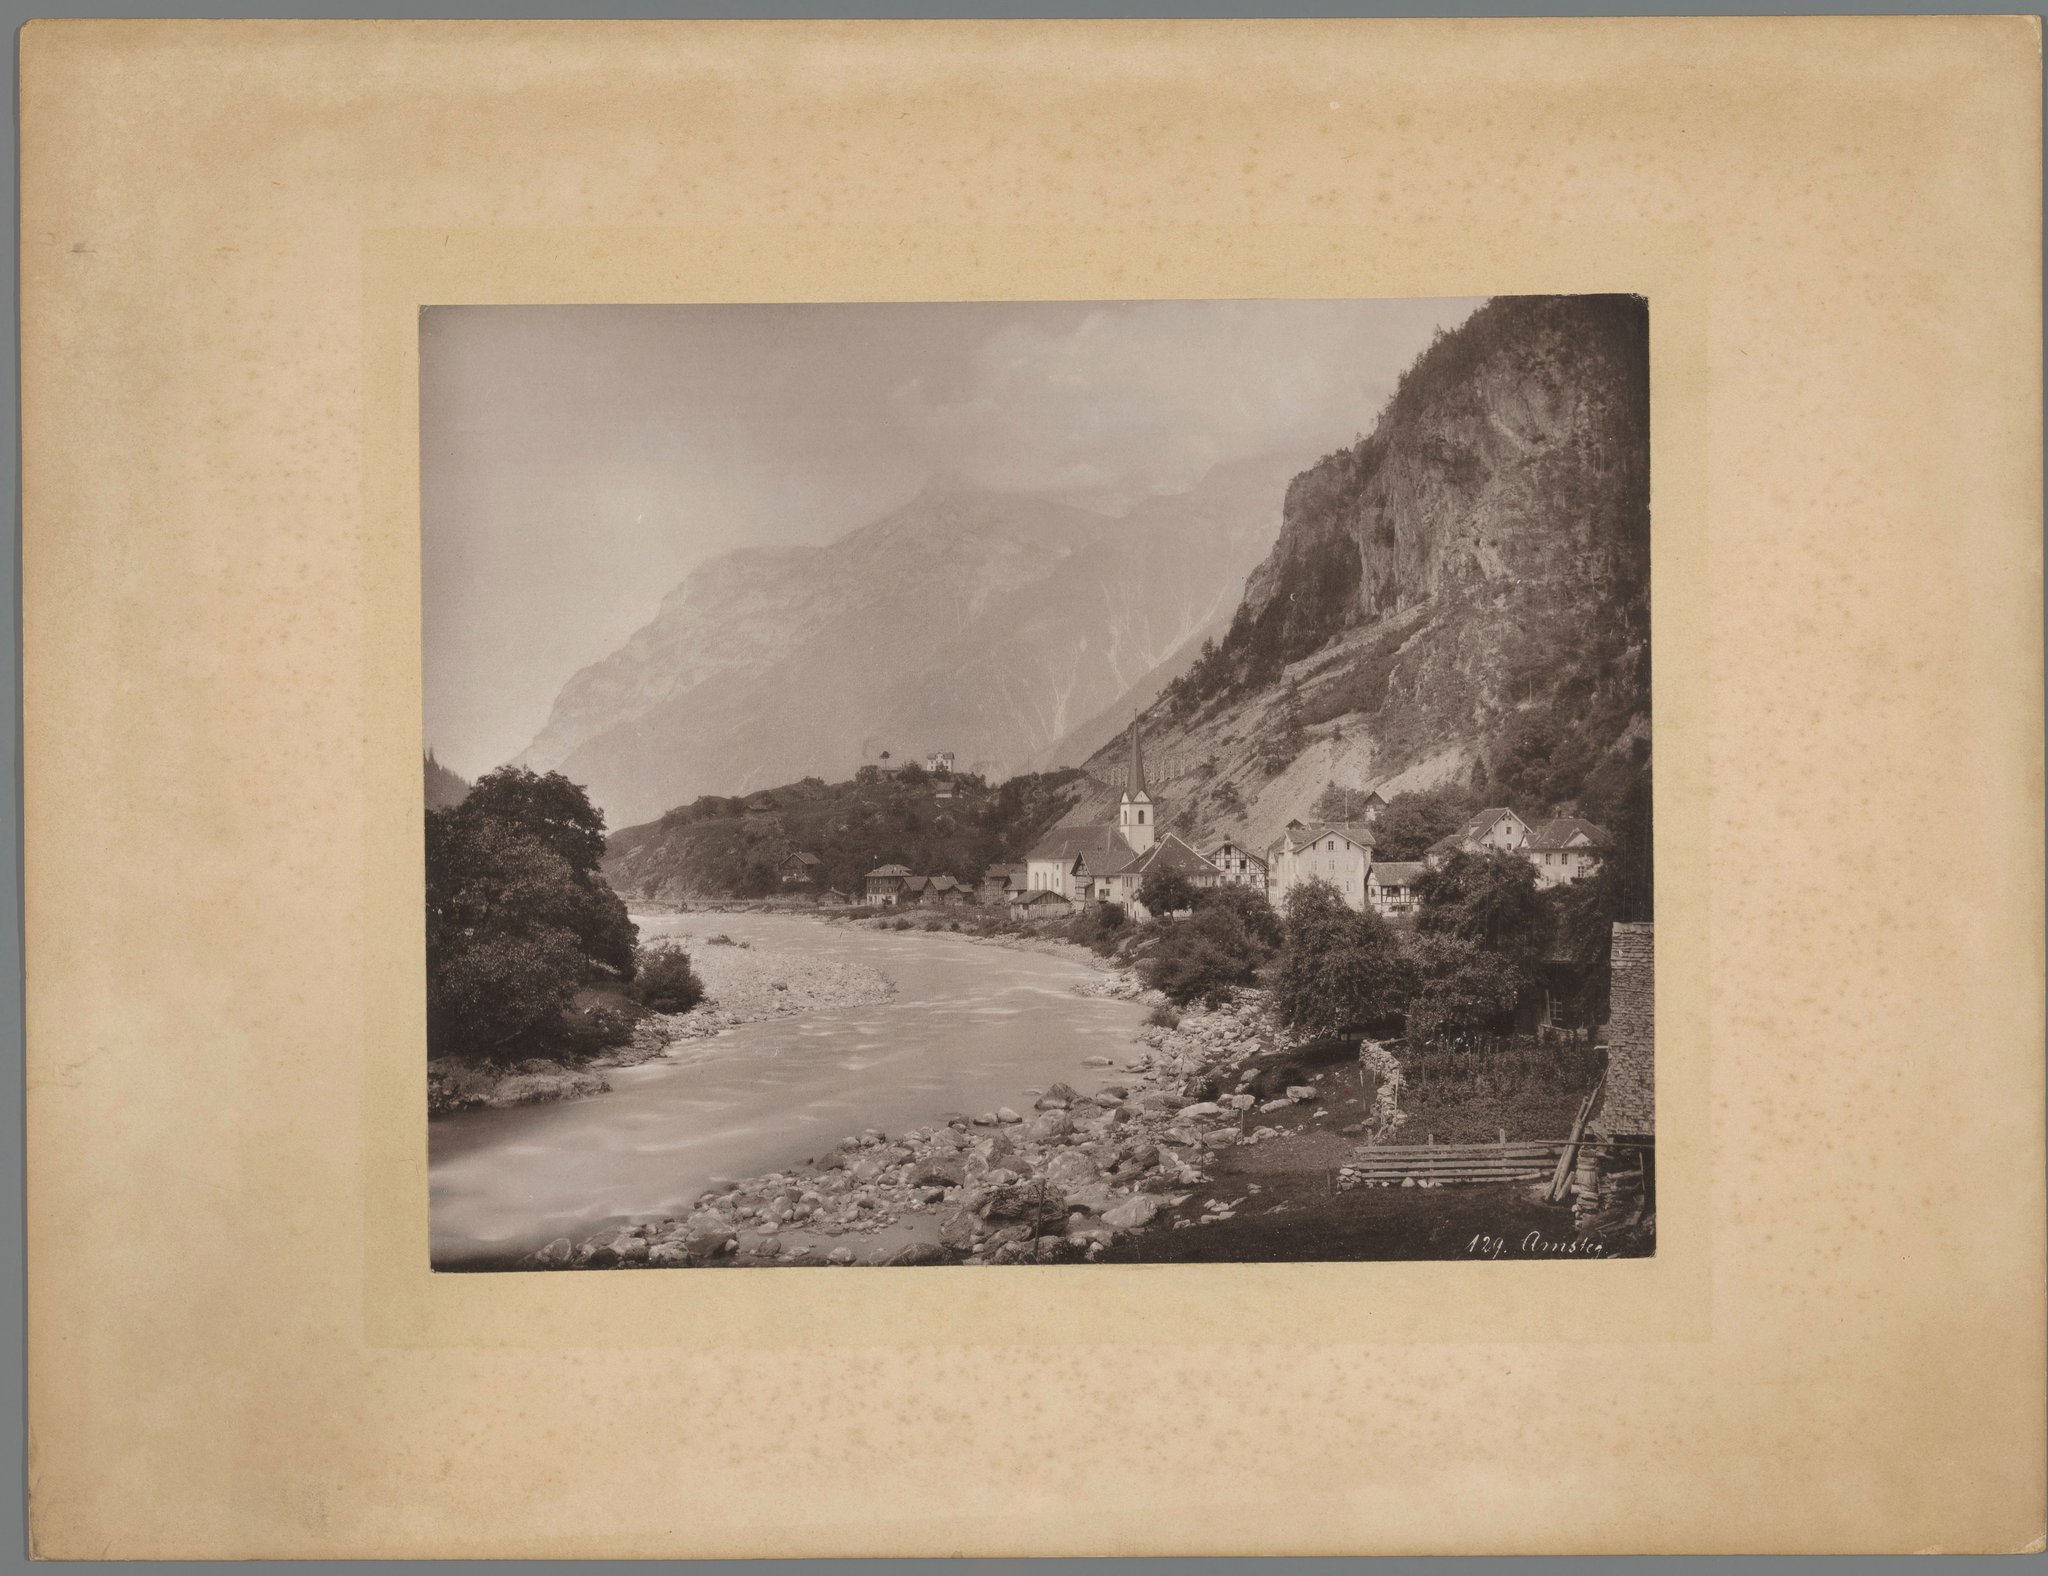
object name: photomechanical print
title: Gezicht op Amsteg aan de Chärstelenbach in Silenen, Zwitserland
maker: Anonymous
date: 1870-1930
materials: cardboard, paper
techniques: photograph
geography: amsteg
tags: river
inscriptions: number: ‘129.’